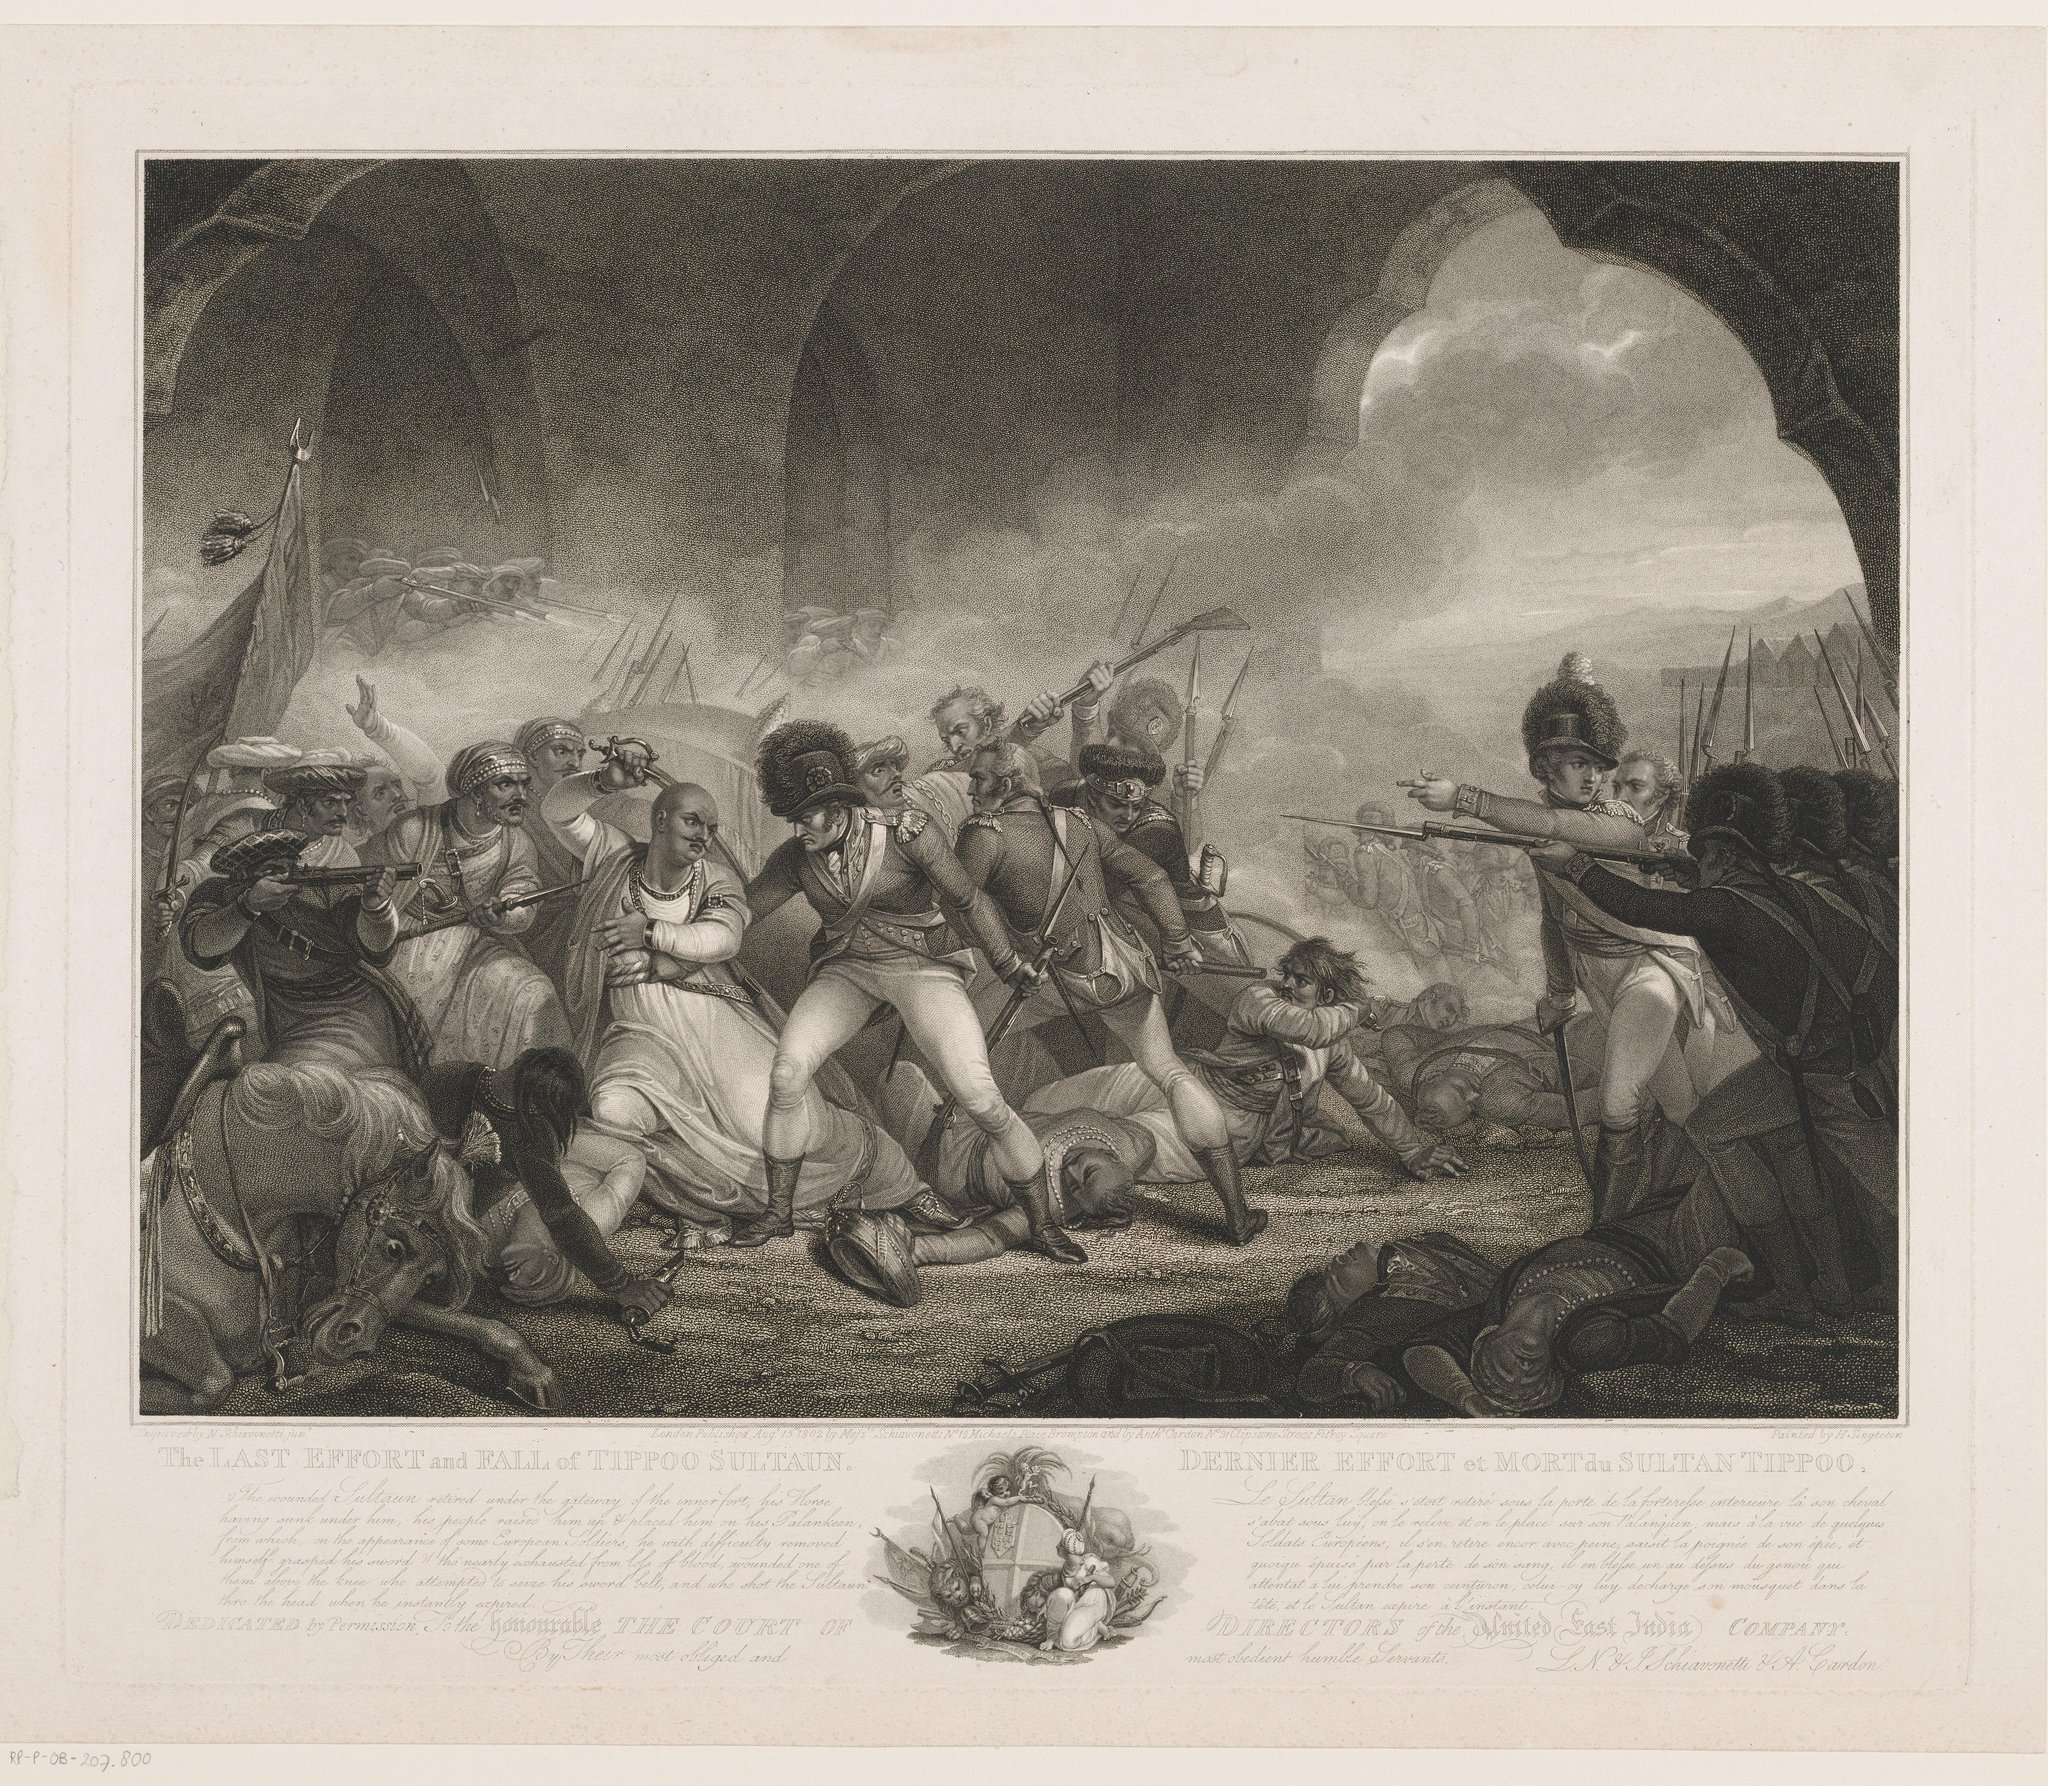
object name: print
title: Laatste strijd van Tipu Sultan van Mysore en zijn leger tegen Europese soldaten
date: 1802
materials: paper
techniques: engraving, etching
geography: london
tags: battle, the soldier; the soldier's life, firearms, fighting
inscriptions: collector's mark: Lugt 12, collector's mark: Lugt 2165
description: Strijdscène met Tipu Sultan van Mysore en zijn leger in gevecht met Europese soldaten. Tekst in het Engels en in het Frans in de ondermarge.